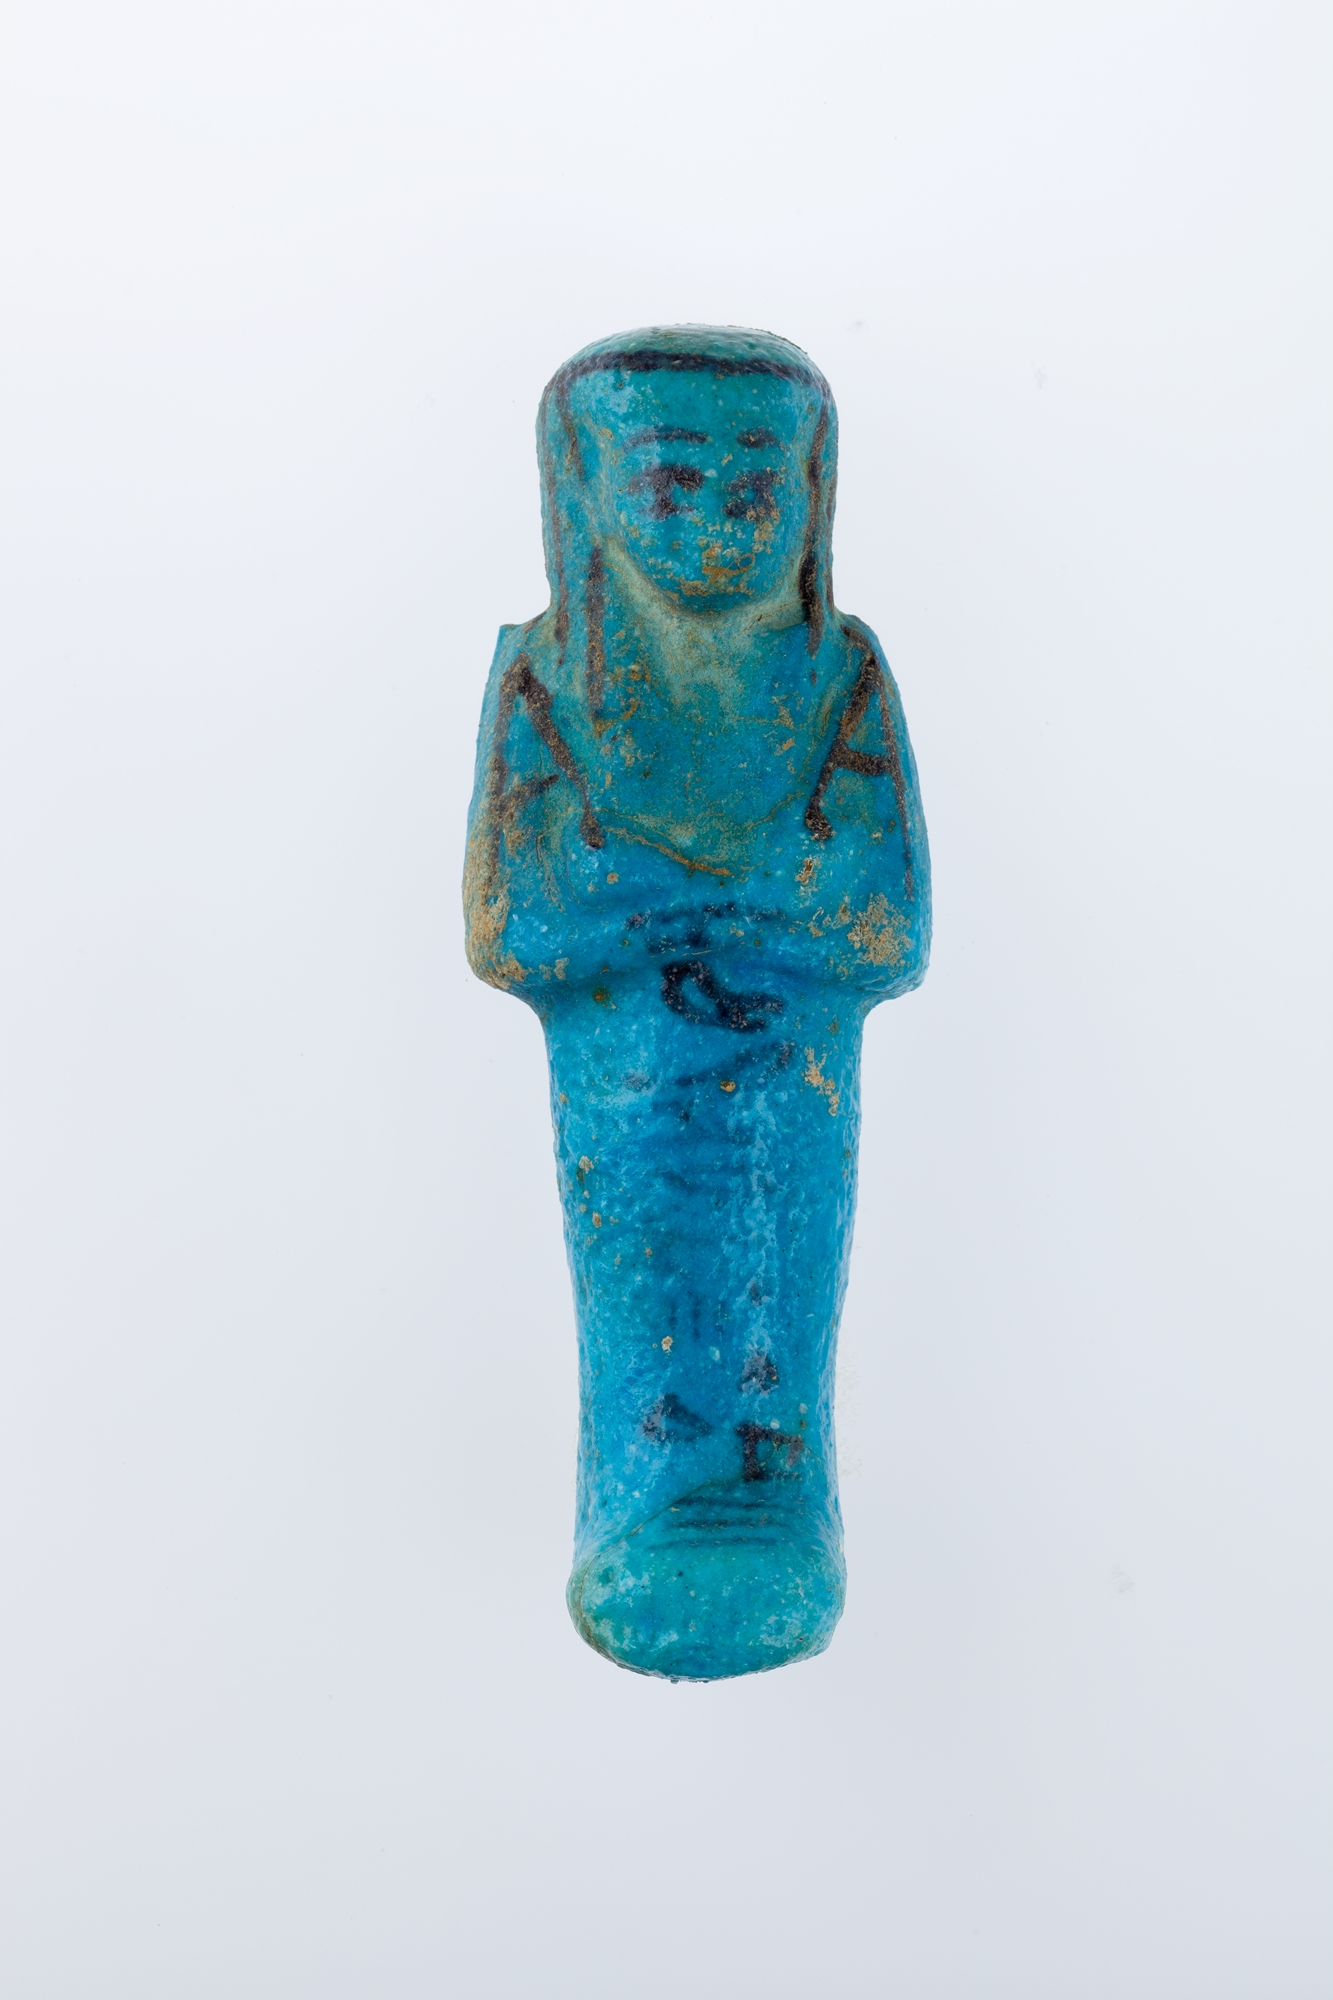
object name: shabti, henettawy c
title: Worker Shabti of Henettawy (C), Daughter of Isetemkheb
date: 990-970 BCE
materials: faience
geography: egypt